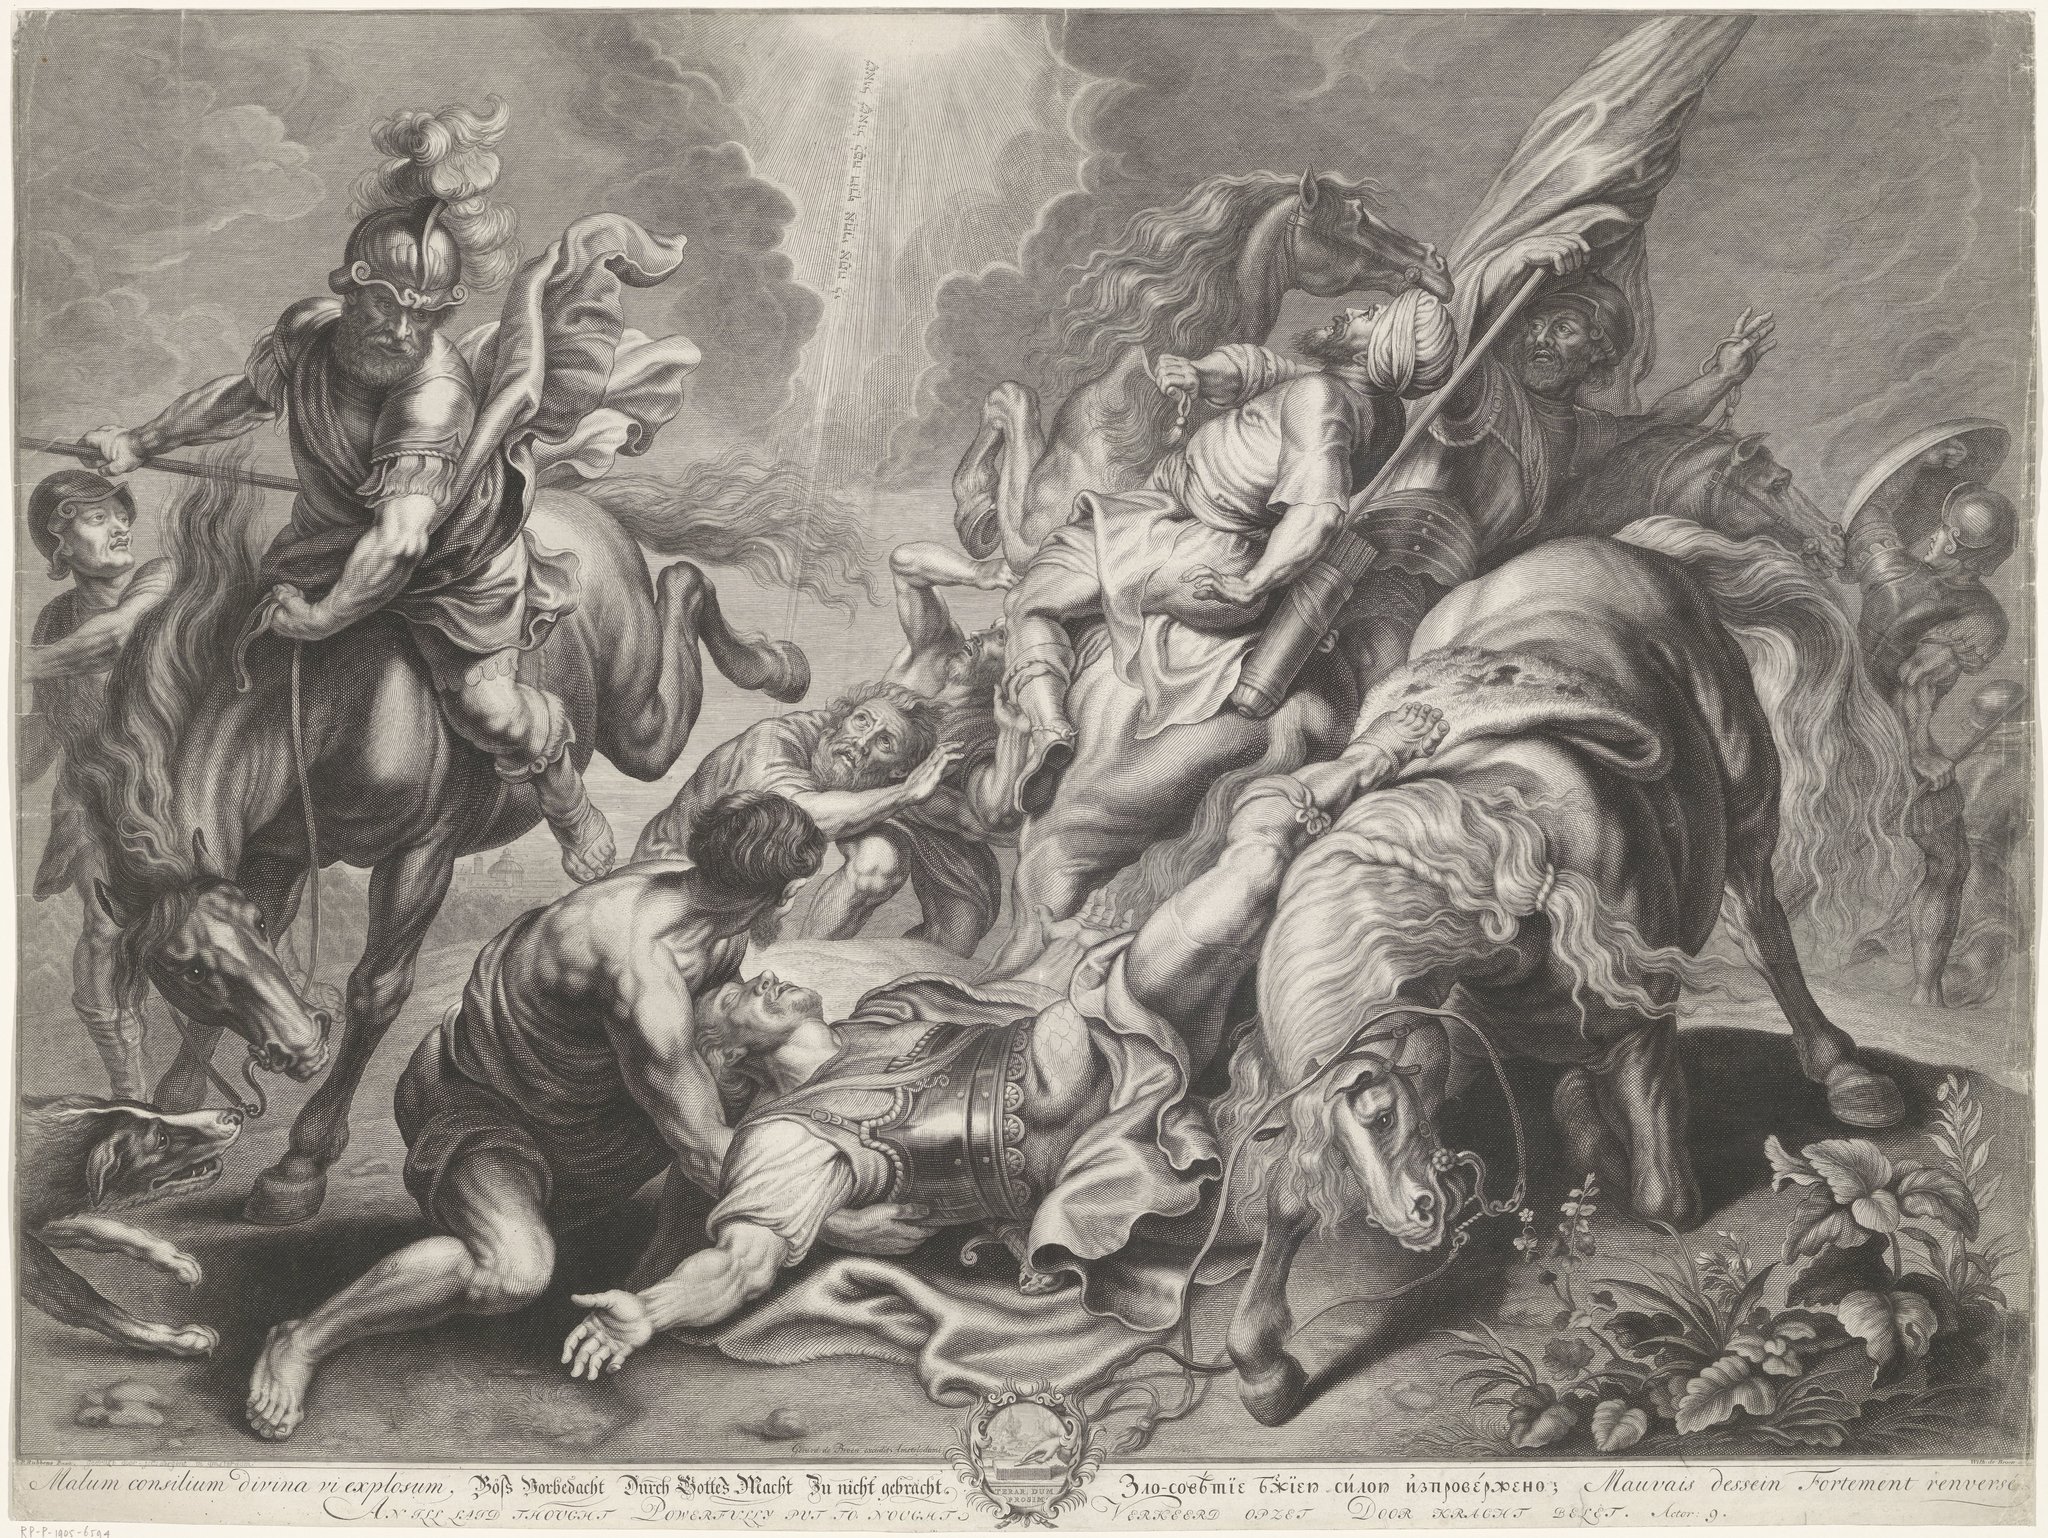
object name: print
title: Bekering van Paulus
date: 1705-1748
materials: paper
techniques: engraving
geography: southern netherlands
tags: on the way to damascus christ appears to saul, who falls from his horse and is blinded by the light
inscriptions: collector's mark: Lugt 2228